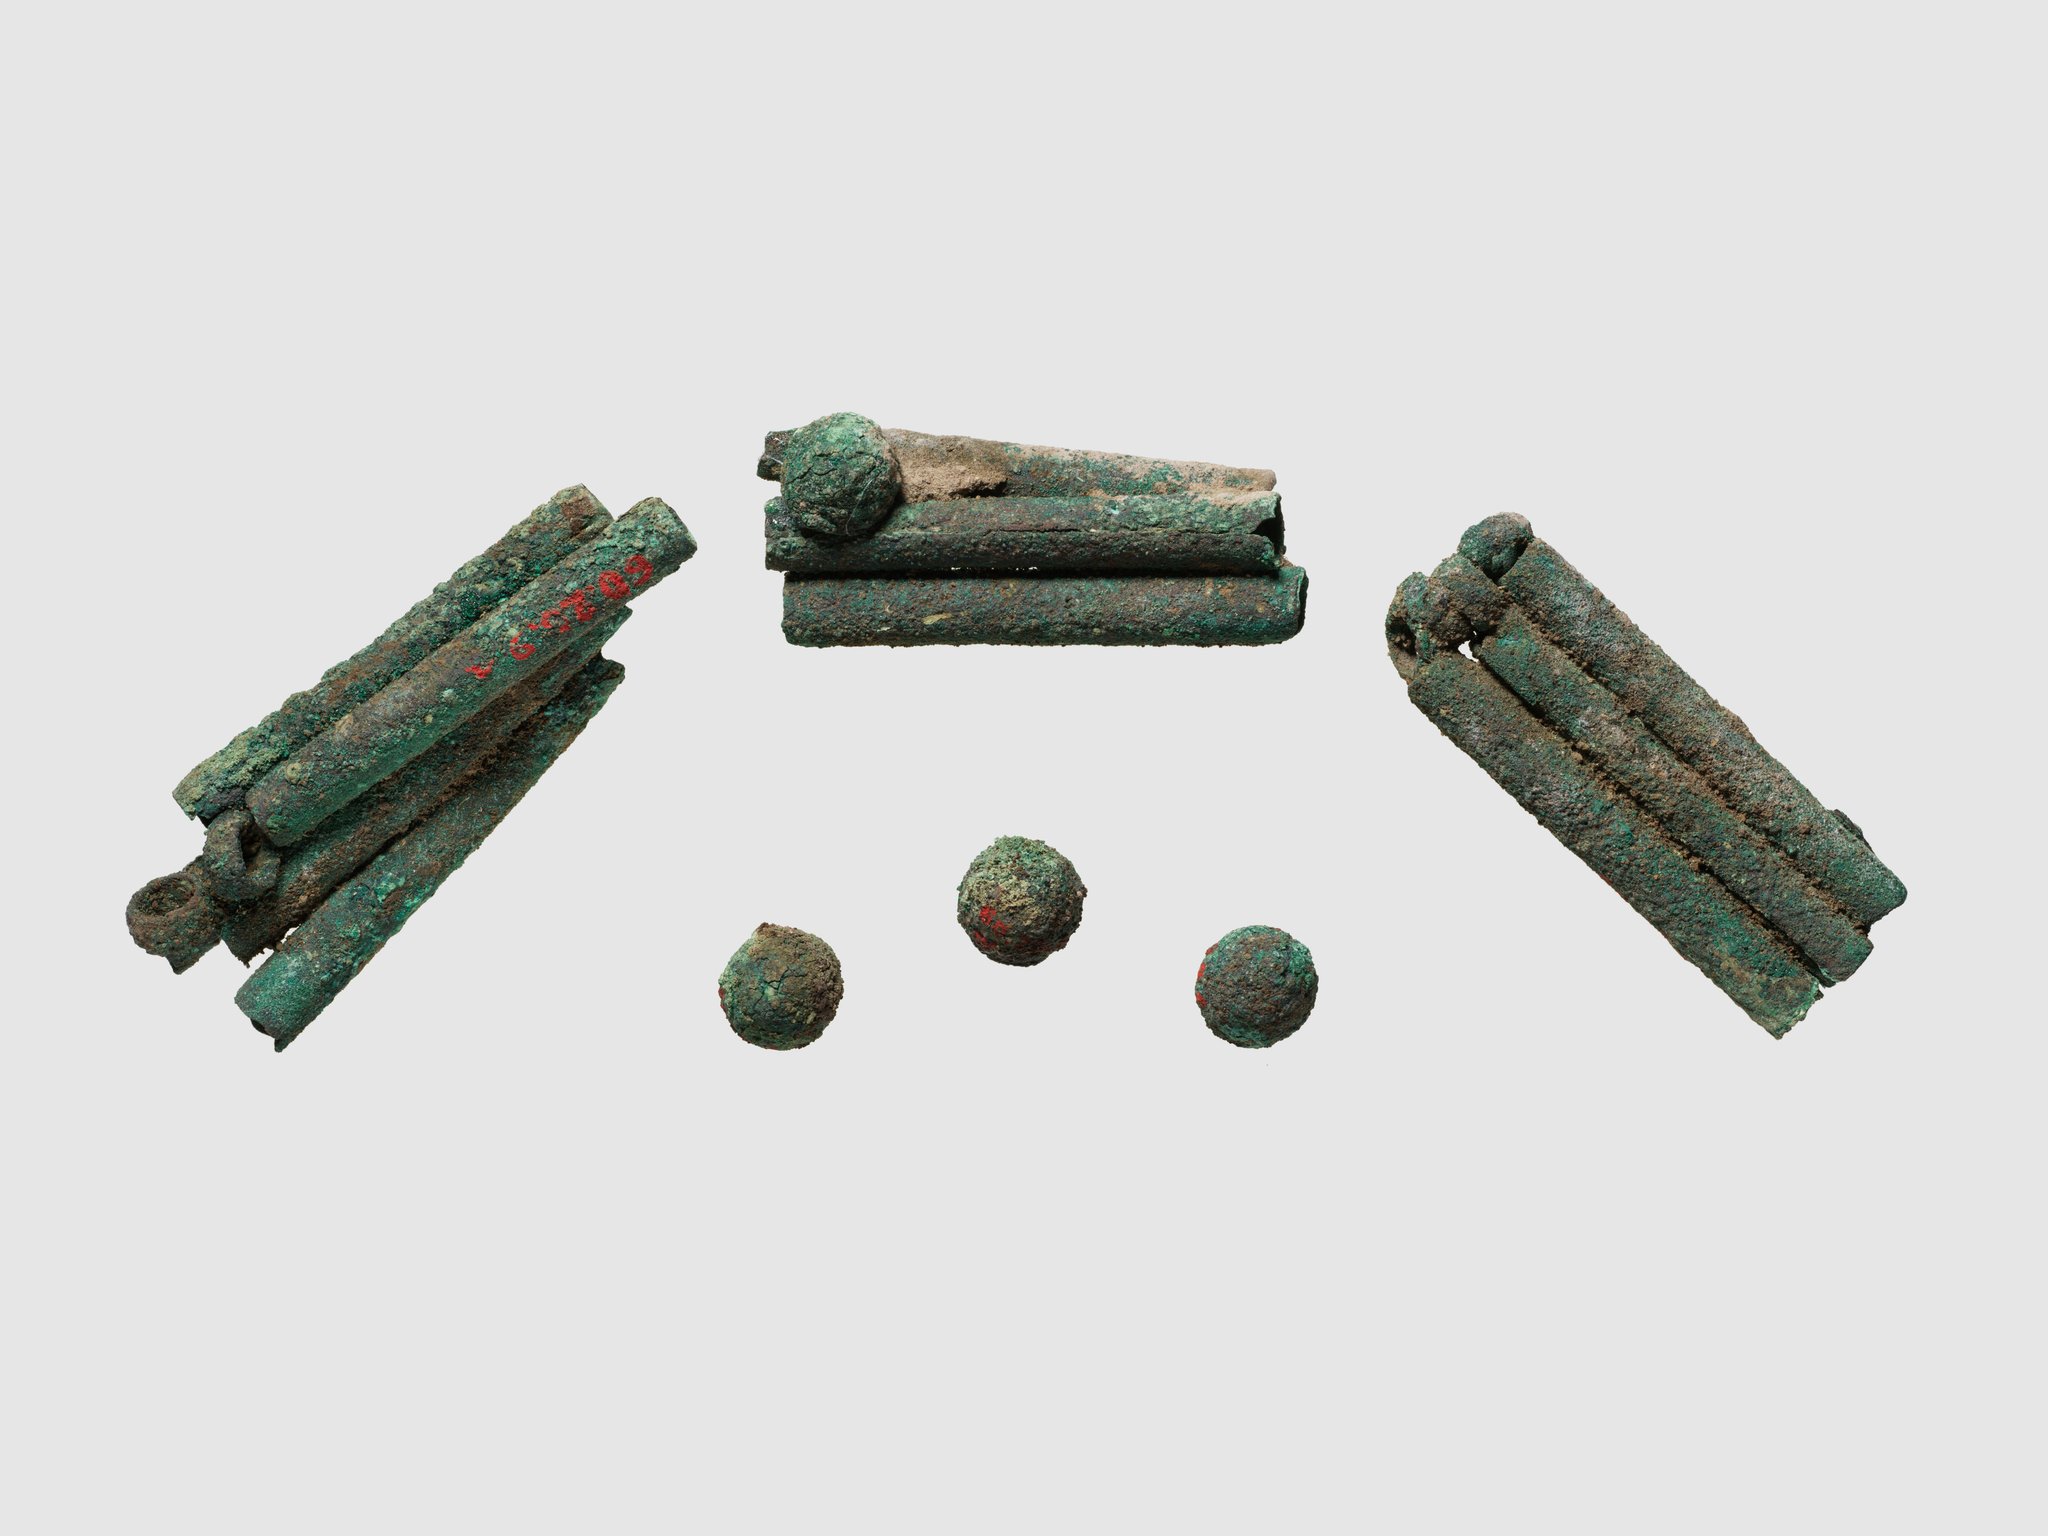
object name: headdress fragment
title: Headdress fragments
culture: iranian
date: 900-801 BCE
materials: bronze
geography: iran